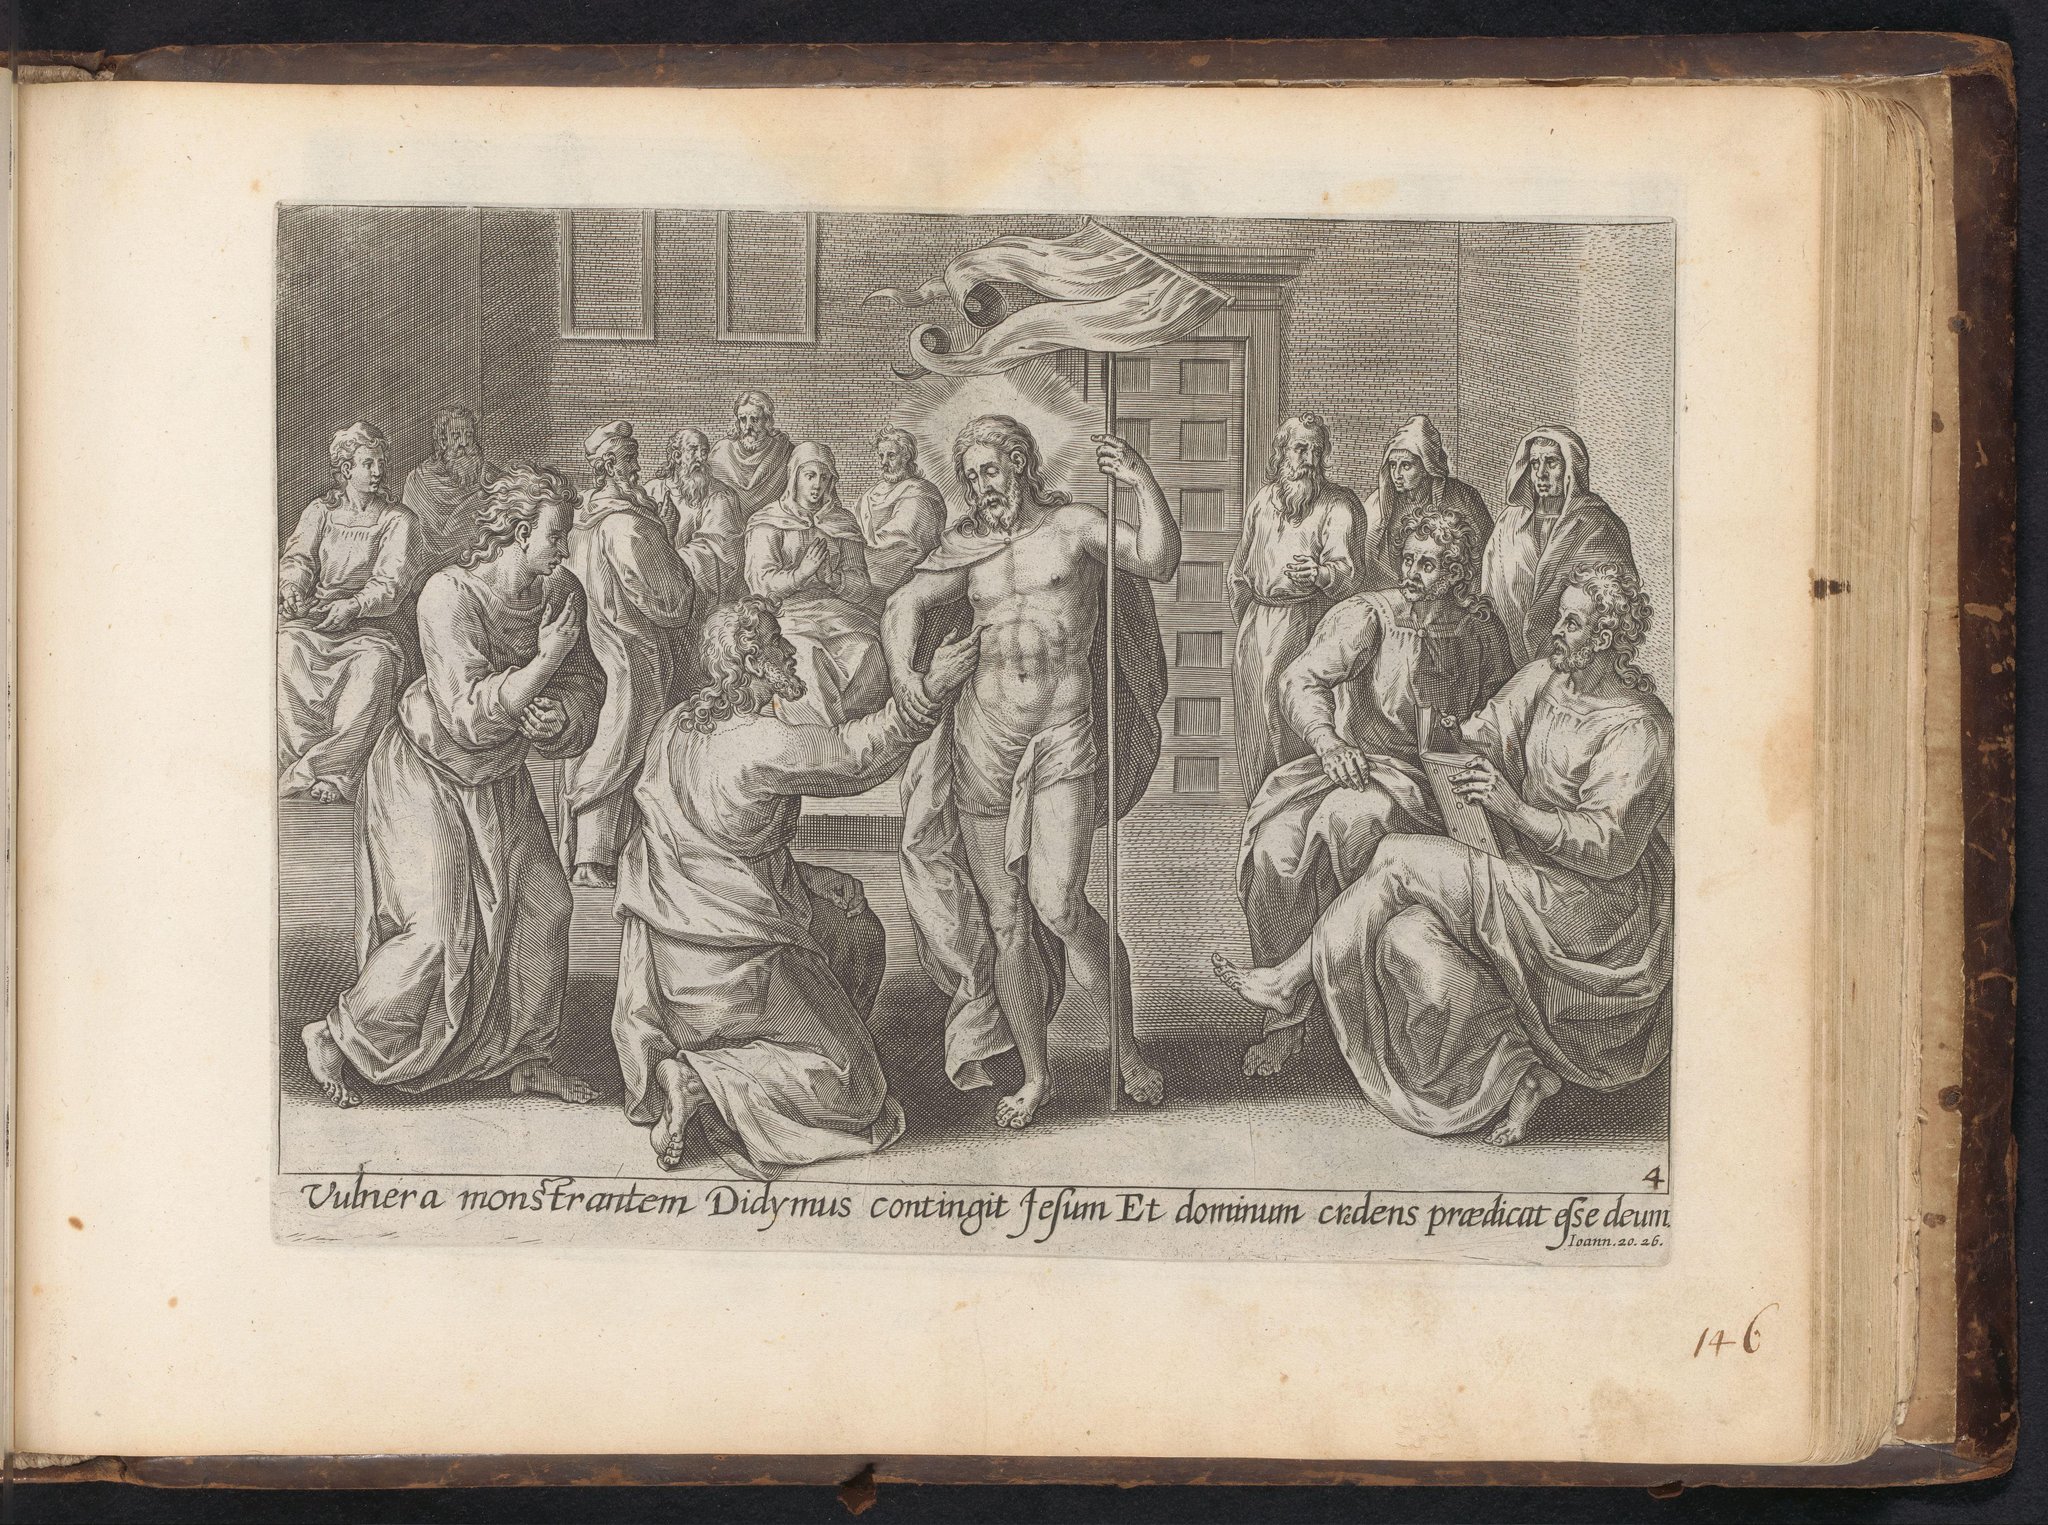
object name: print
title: Openbaringen Iesu nasijn Verrysenisse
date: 1585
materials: paper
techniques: engraving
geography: alkmaar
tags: thomas touching or stretching out his hands to touch the wound in christ's side, sometimes christ leading thomas' hand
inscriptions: serial number: ‘4’, number: ‘146’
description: Christus verschijnt aan de discipelen en aan Tomas. Hij houdt een overwinningsbanier in de hand en laat Tomas zijn wonden aanraken. Onder de voorstelling een verwijzing in het Latijn naar de Bijbeltekst in Joh. 20:26. Deze prent maakt deel uit van een album.